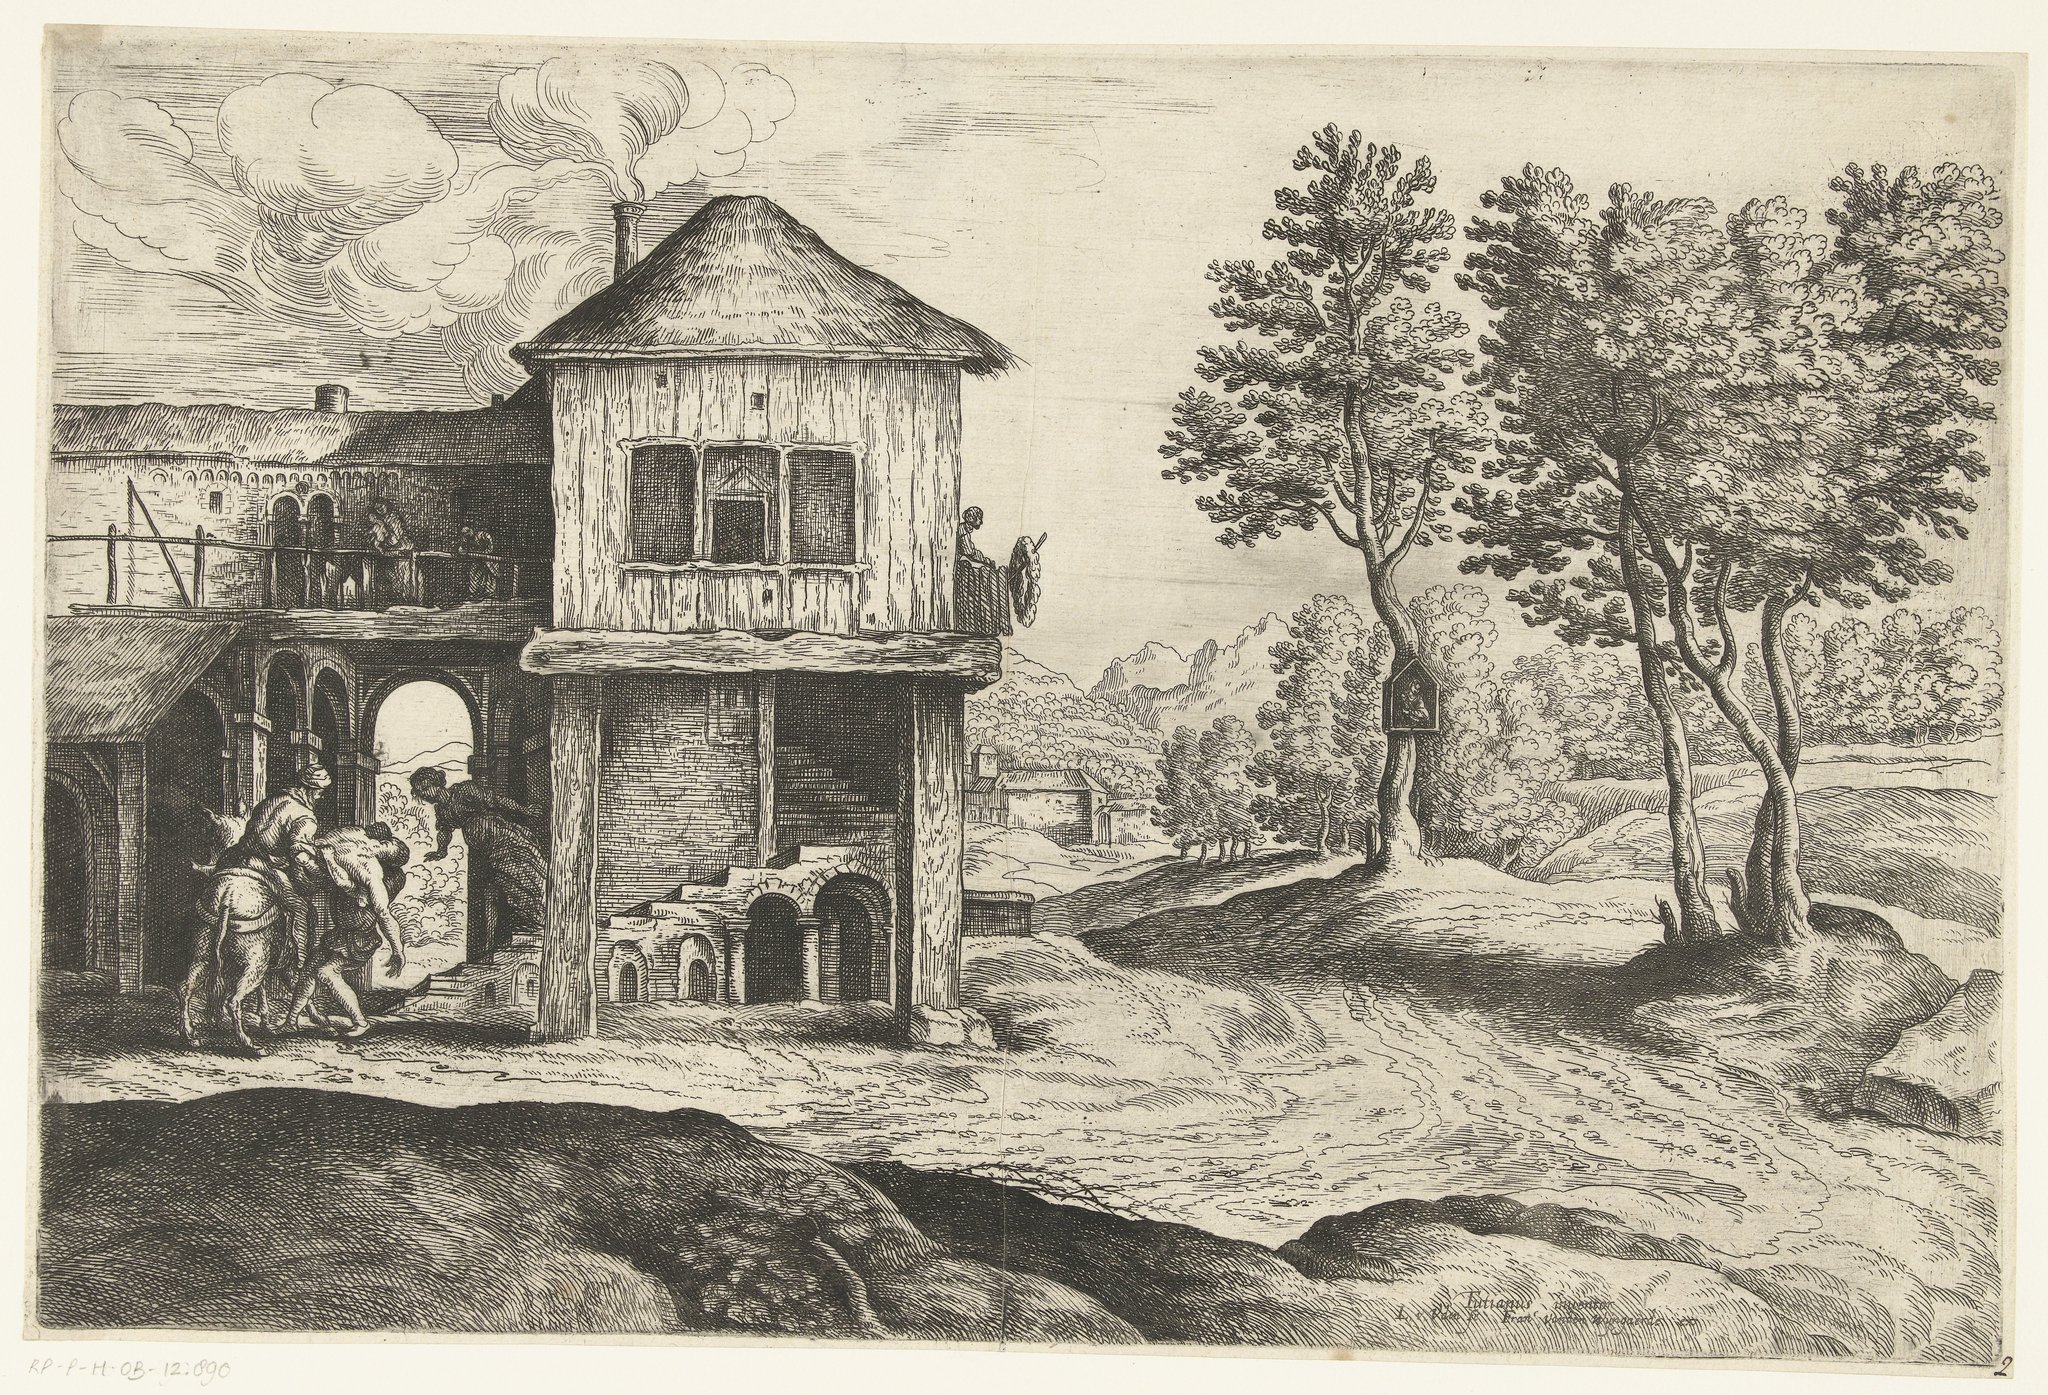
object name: print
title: Barmhartige Samaritaan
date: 1605-1673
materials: paper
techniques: engraving, etching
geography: low countries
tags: the samaritan and the wounded traveller arrive at the inn; the traveller is cared for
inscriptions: number: ‘2’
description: De barmhartige Samaritaan te paard levert reiziger af bij een herberg.